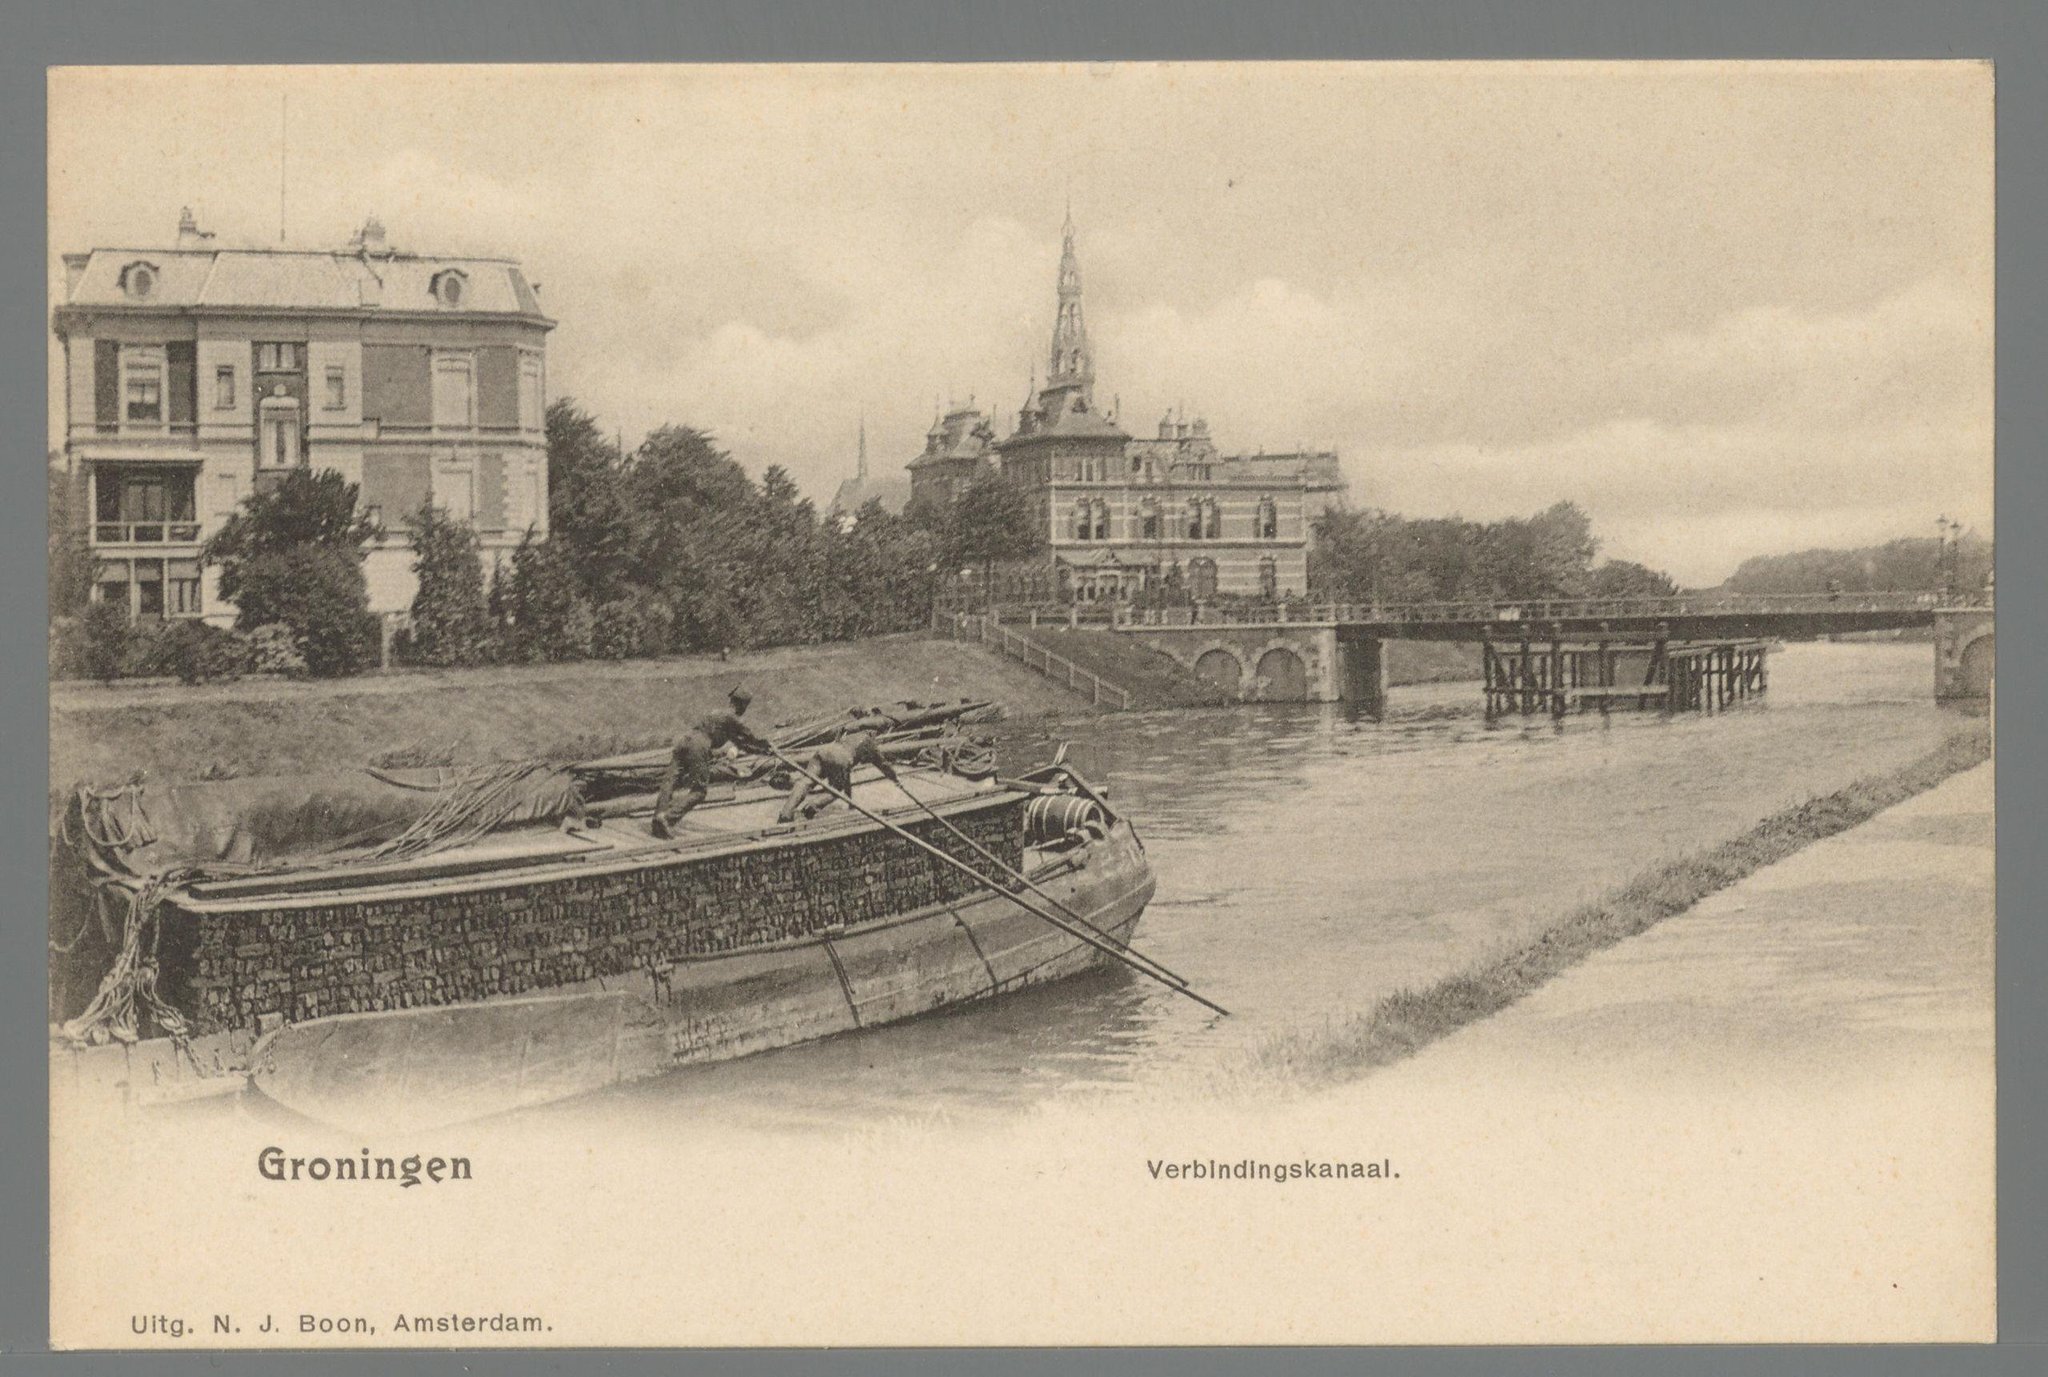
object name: photomechanical print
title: Groningen. Verbindingskanaal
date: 1897-1905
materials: cardboard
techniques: photograph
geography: amsterdam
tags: city-view, and landscape with man-made constructions, sailing-ship, sailing-boat, canal